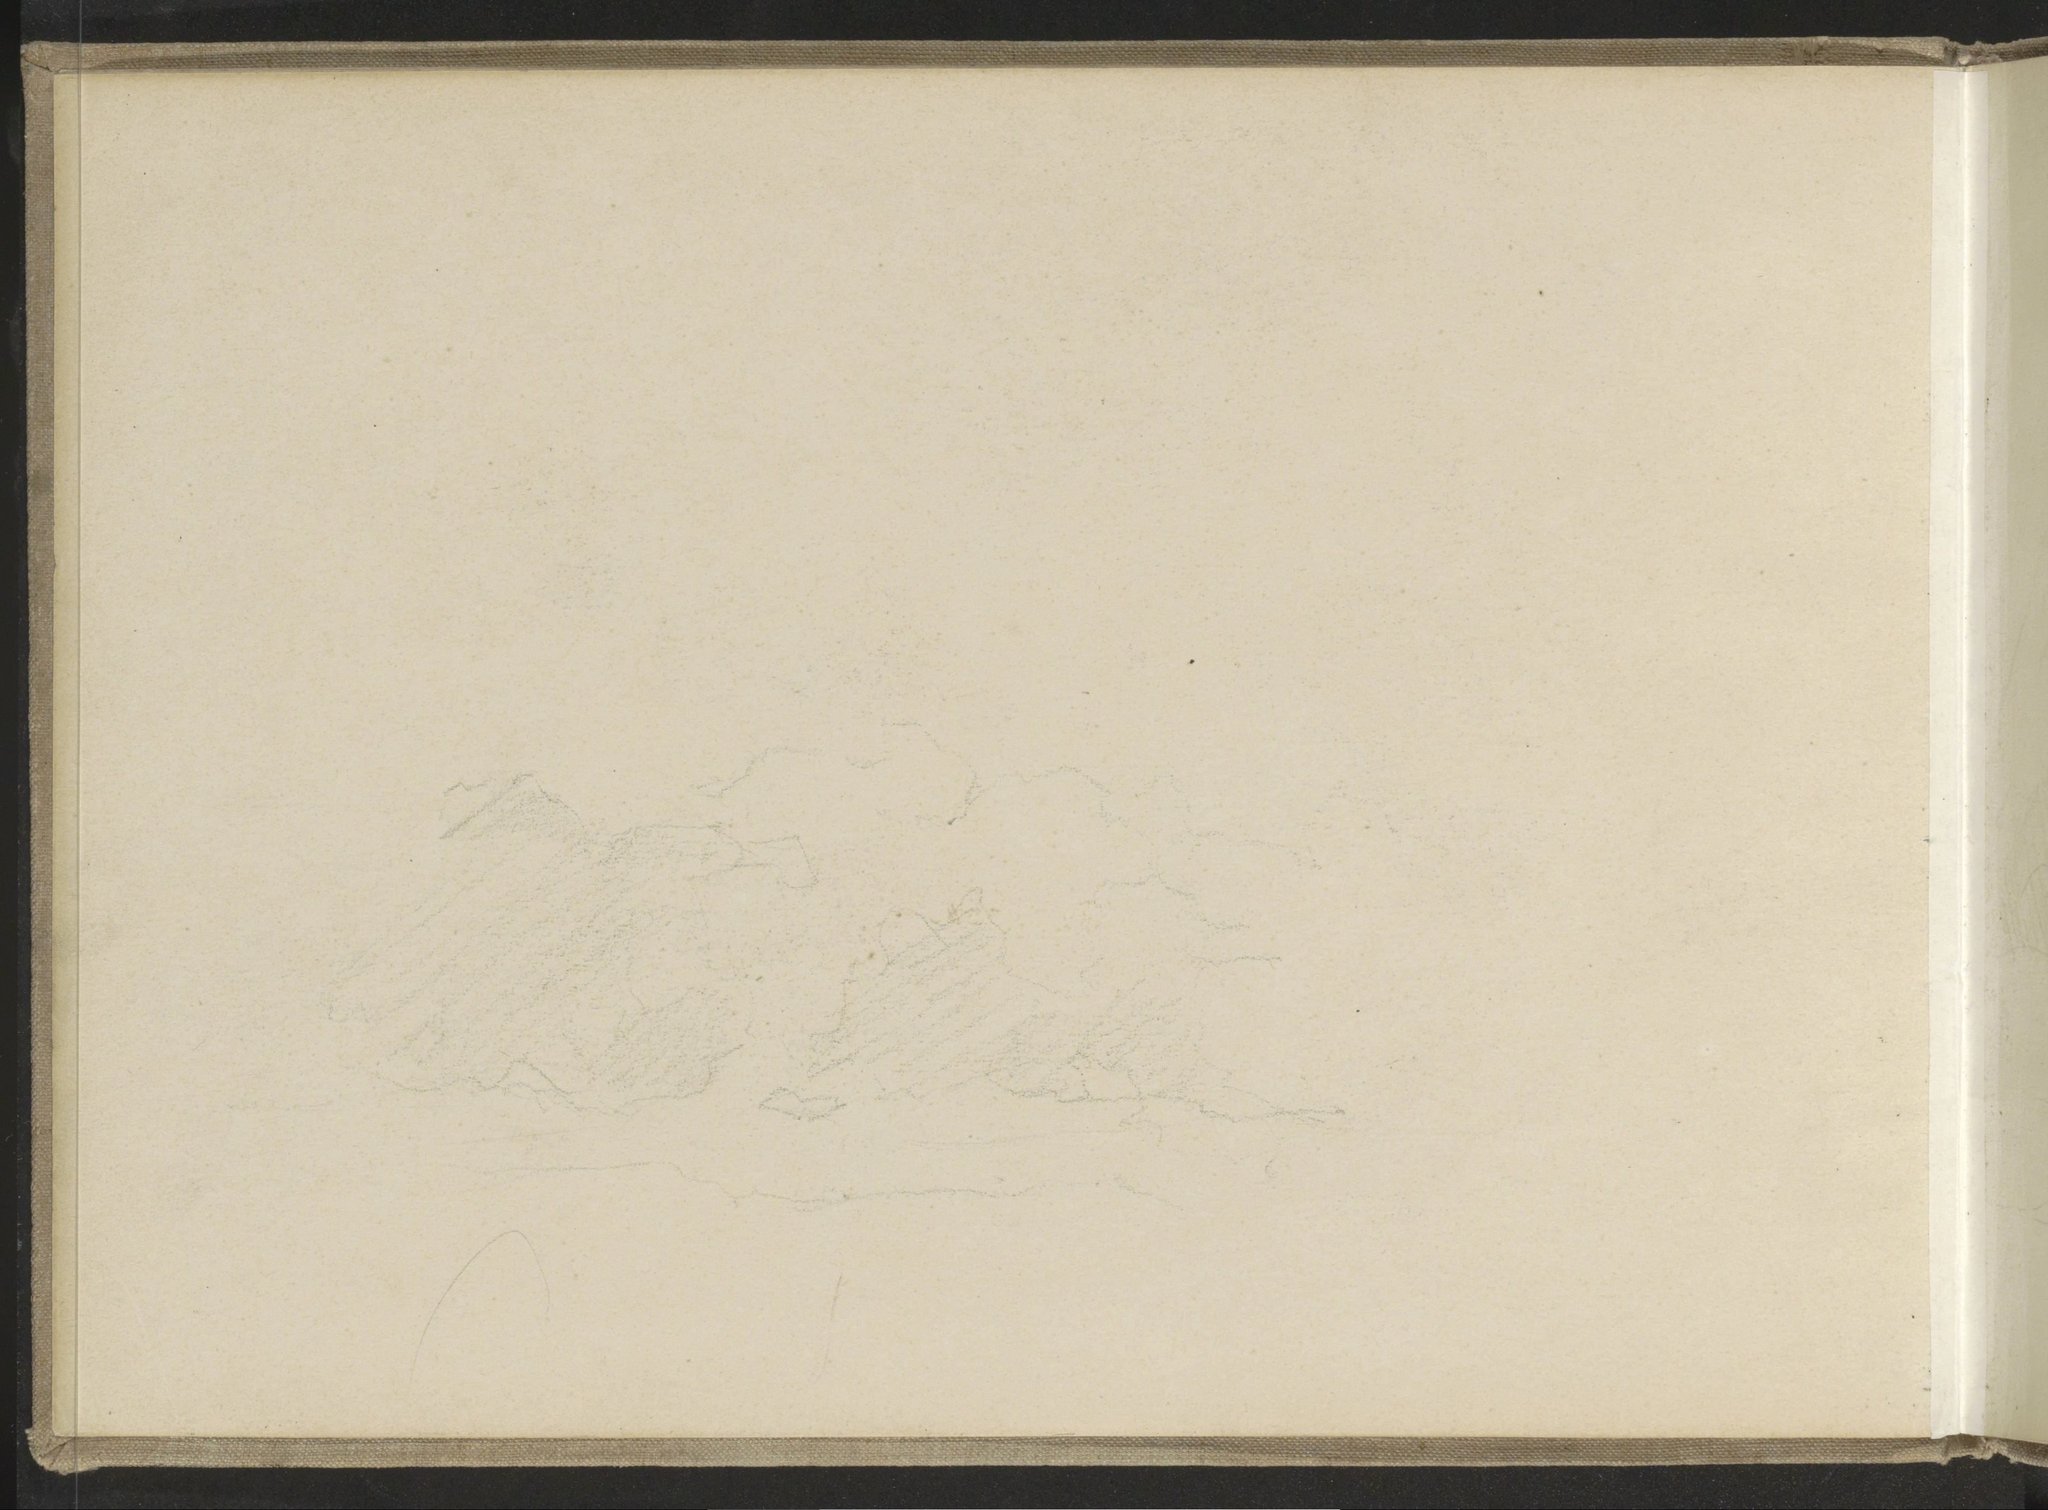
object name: sketchbook leaf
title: Wolken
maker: jozef israëls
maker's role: draughtsman, painter, print maker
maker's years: 1824-1911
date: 1834-1911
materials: paper, pencil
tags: clouds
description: Blad 1 verso uit een schetsboek met 27 bladen.